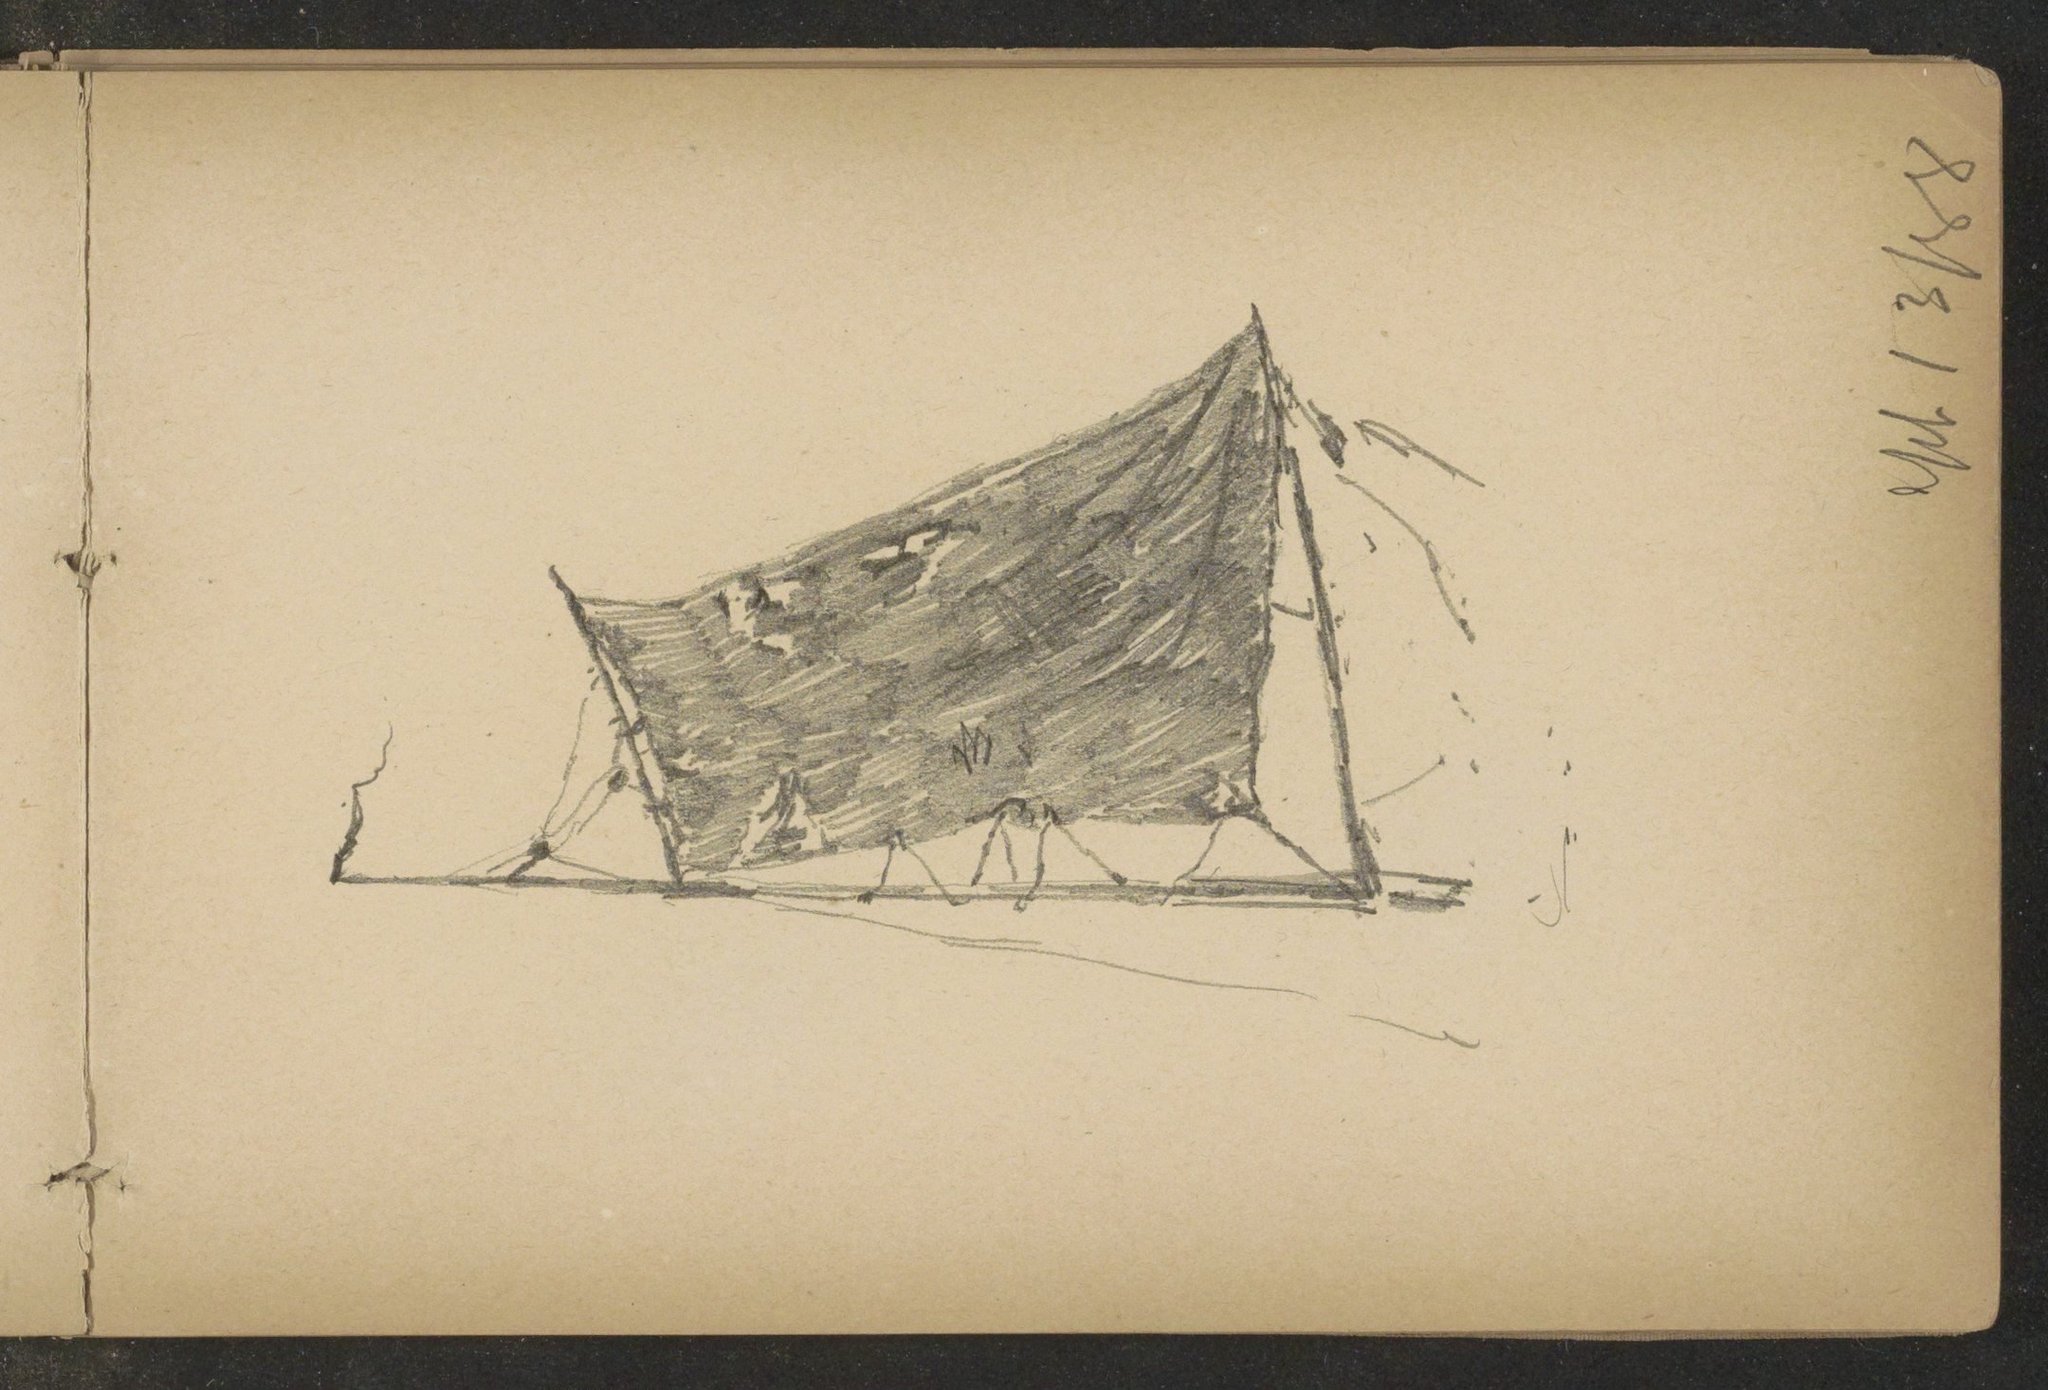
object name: sketchbook leaf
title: Zeil van een schip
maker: alexander shilling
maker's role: draughtsman, print maker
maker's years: 1859-1937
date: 1809-1888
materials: paper, pencil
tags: sail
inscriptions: date: ‘sept 13/88’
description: Blad 14 recto uit een schetsboek met 34 bladen.